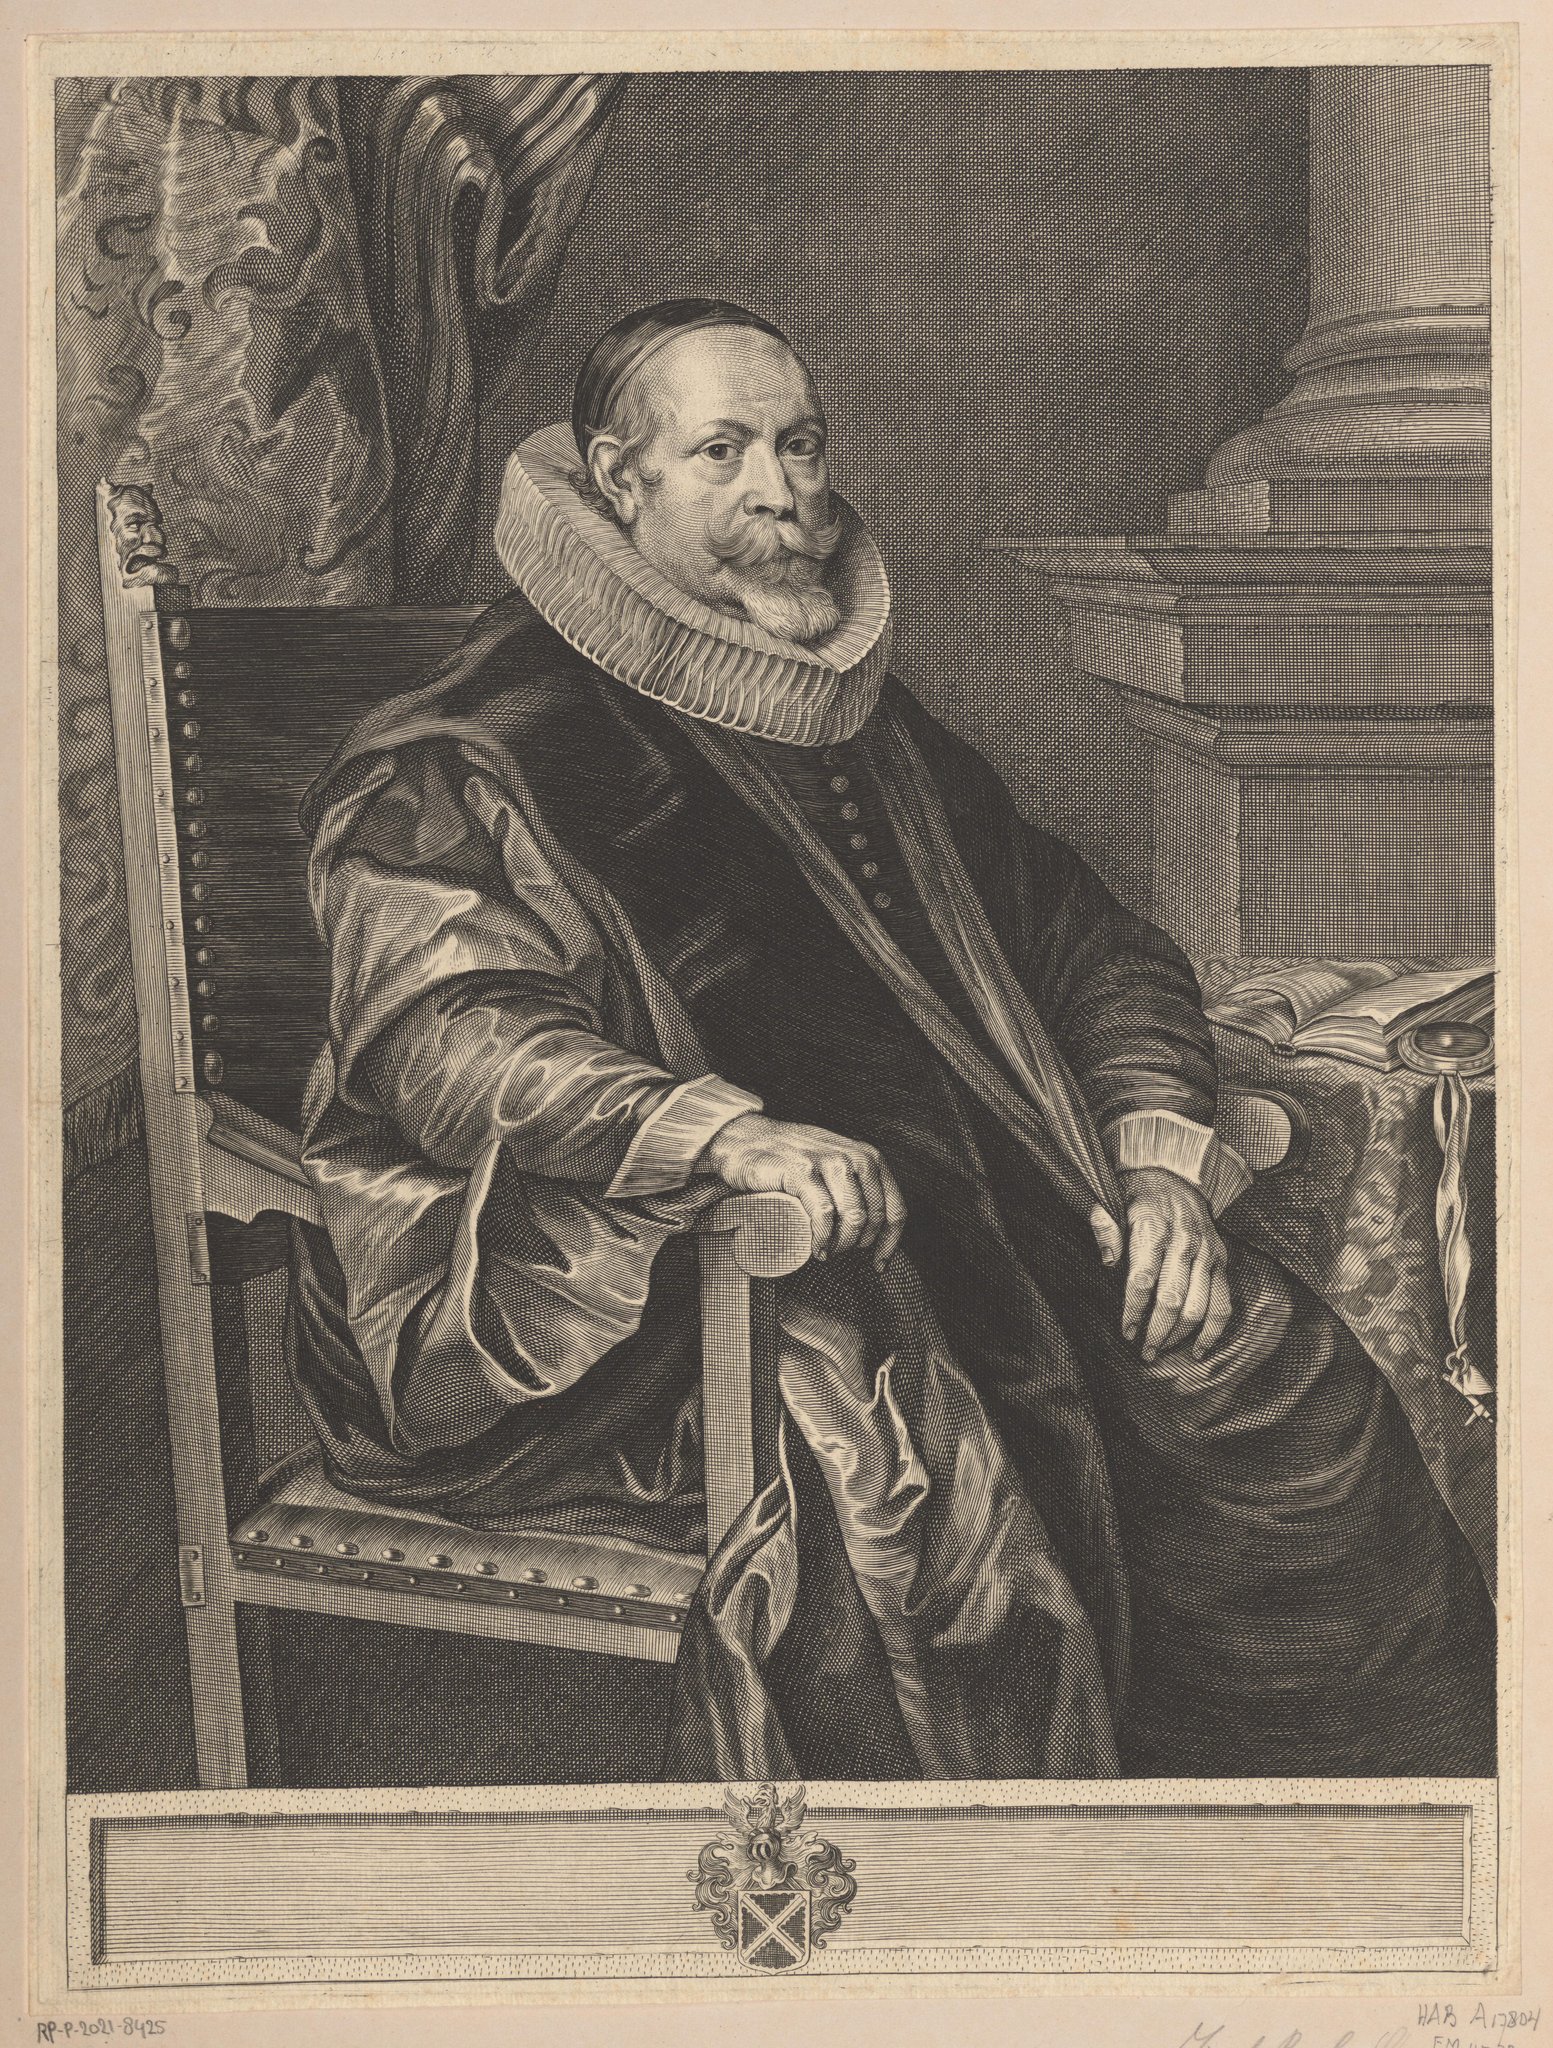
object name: print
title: Portret van Jacob Roelants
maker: paulus pontius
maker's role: draughtsman, print maker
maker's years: 1603-1658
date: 1623-1658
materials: paper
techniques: engraving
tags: sitting figure, historical persons, book, chair, armorial bearing, heraldry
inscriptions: collector's mark: Lugt 240